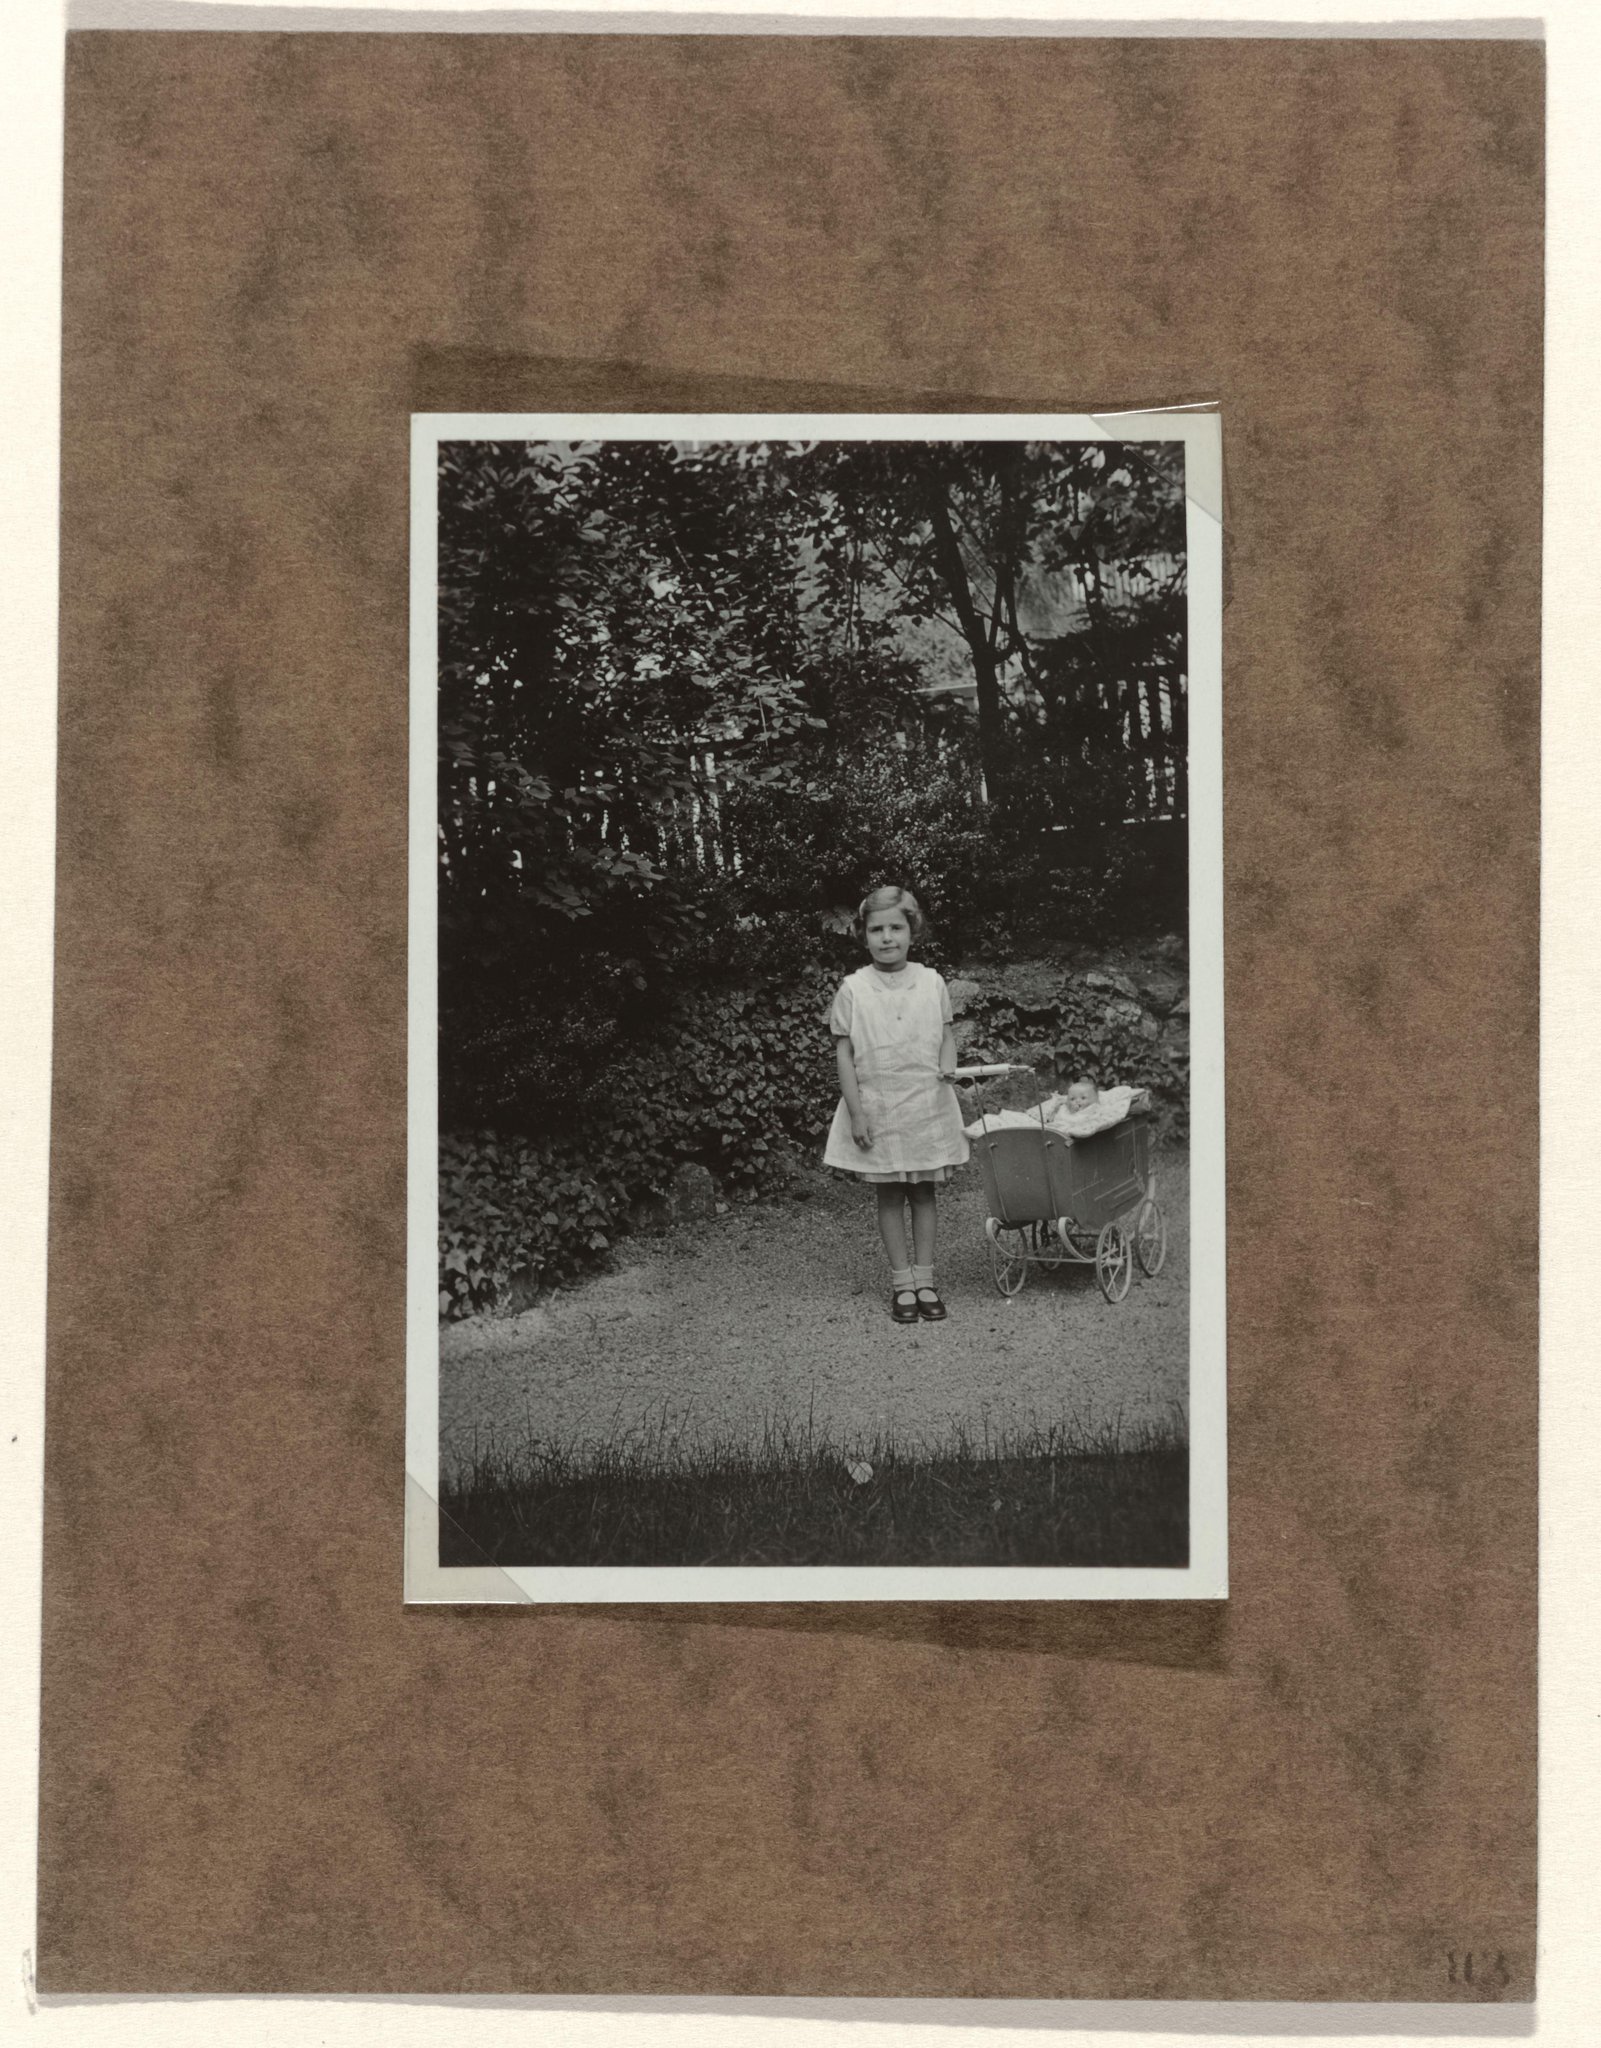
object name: photograph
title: Isabel Wachenheimer in een tuin met een kinderwagen met daarin een pop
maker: Anonymous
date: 1931-1937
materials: photographic support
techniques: gelatin silver print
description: Isabel Wachenheimer in een tuin met een kinderwagen met daarin een pop.